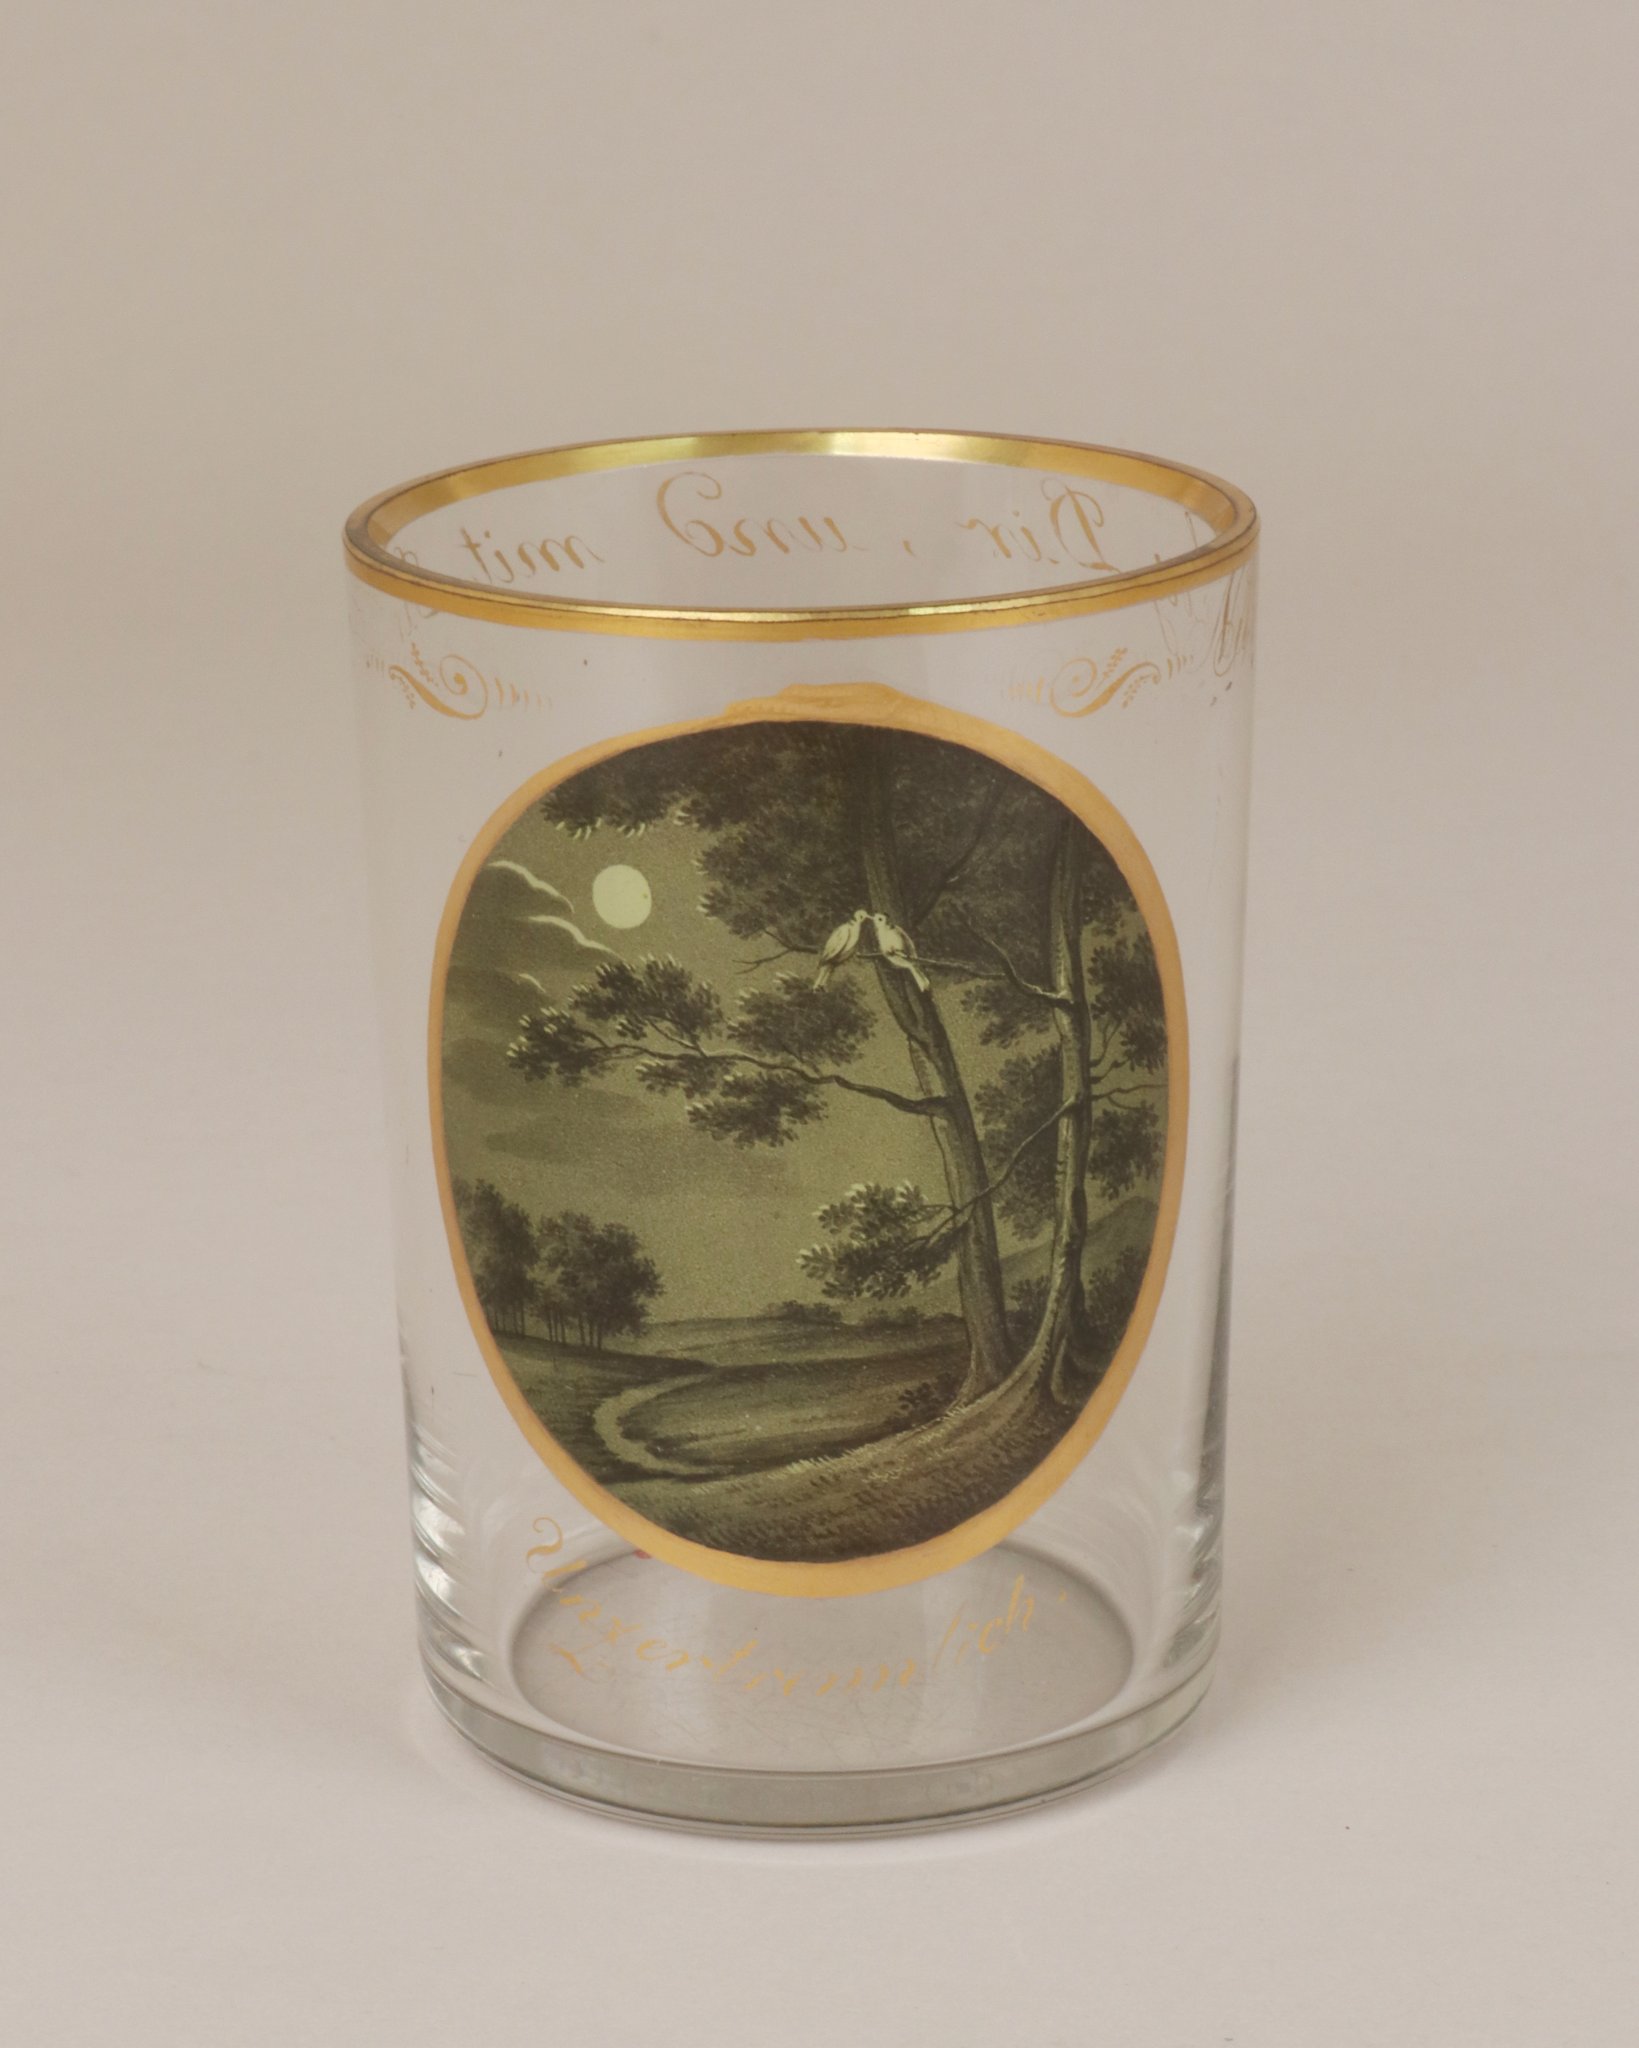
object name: beaker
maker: anton kothgasser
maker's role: decorator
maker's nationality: austrian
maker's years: 1769-1851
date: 1801-1833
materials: glass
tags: birds,moon,landscapes